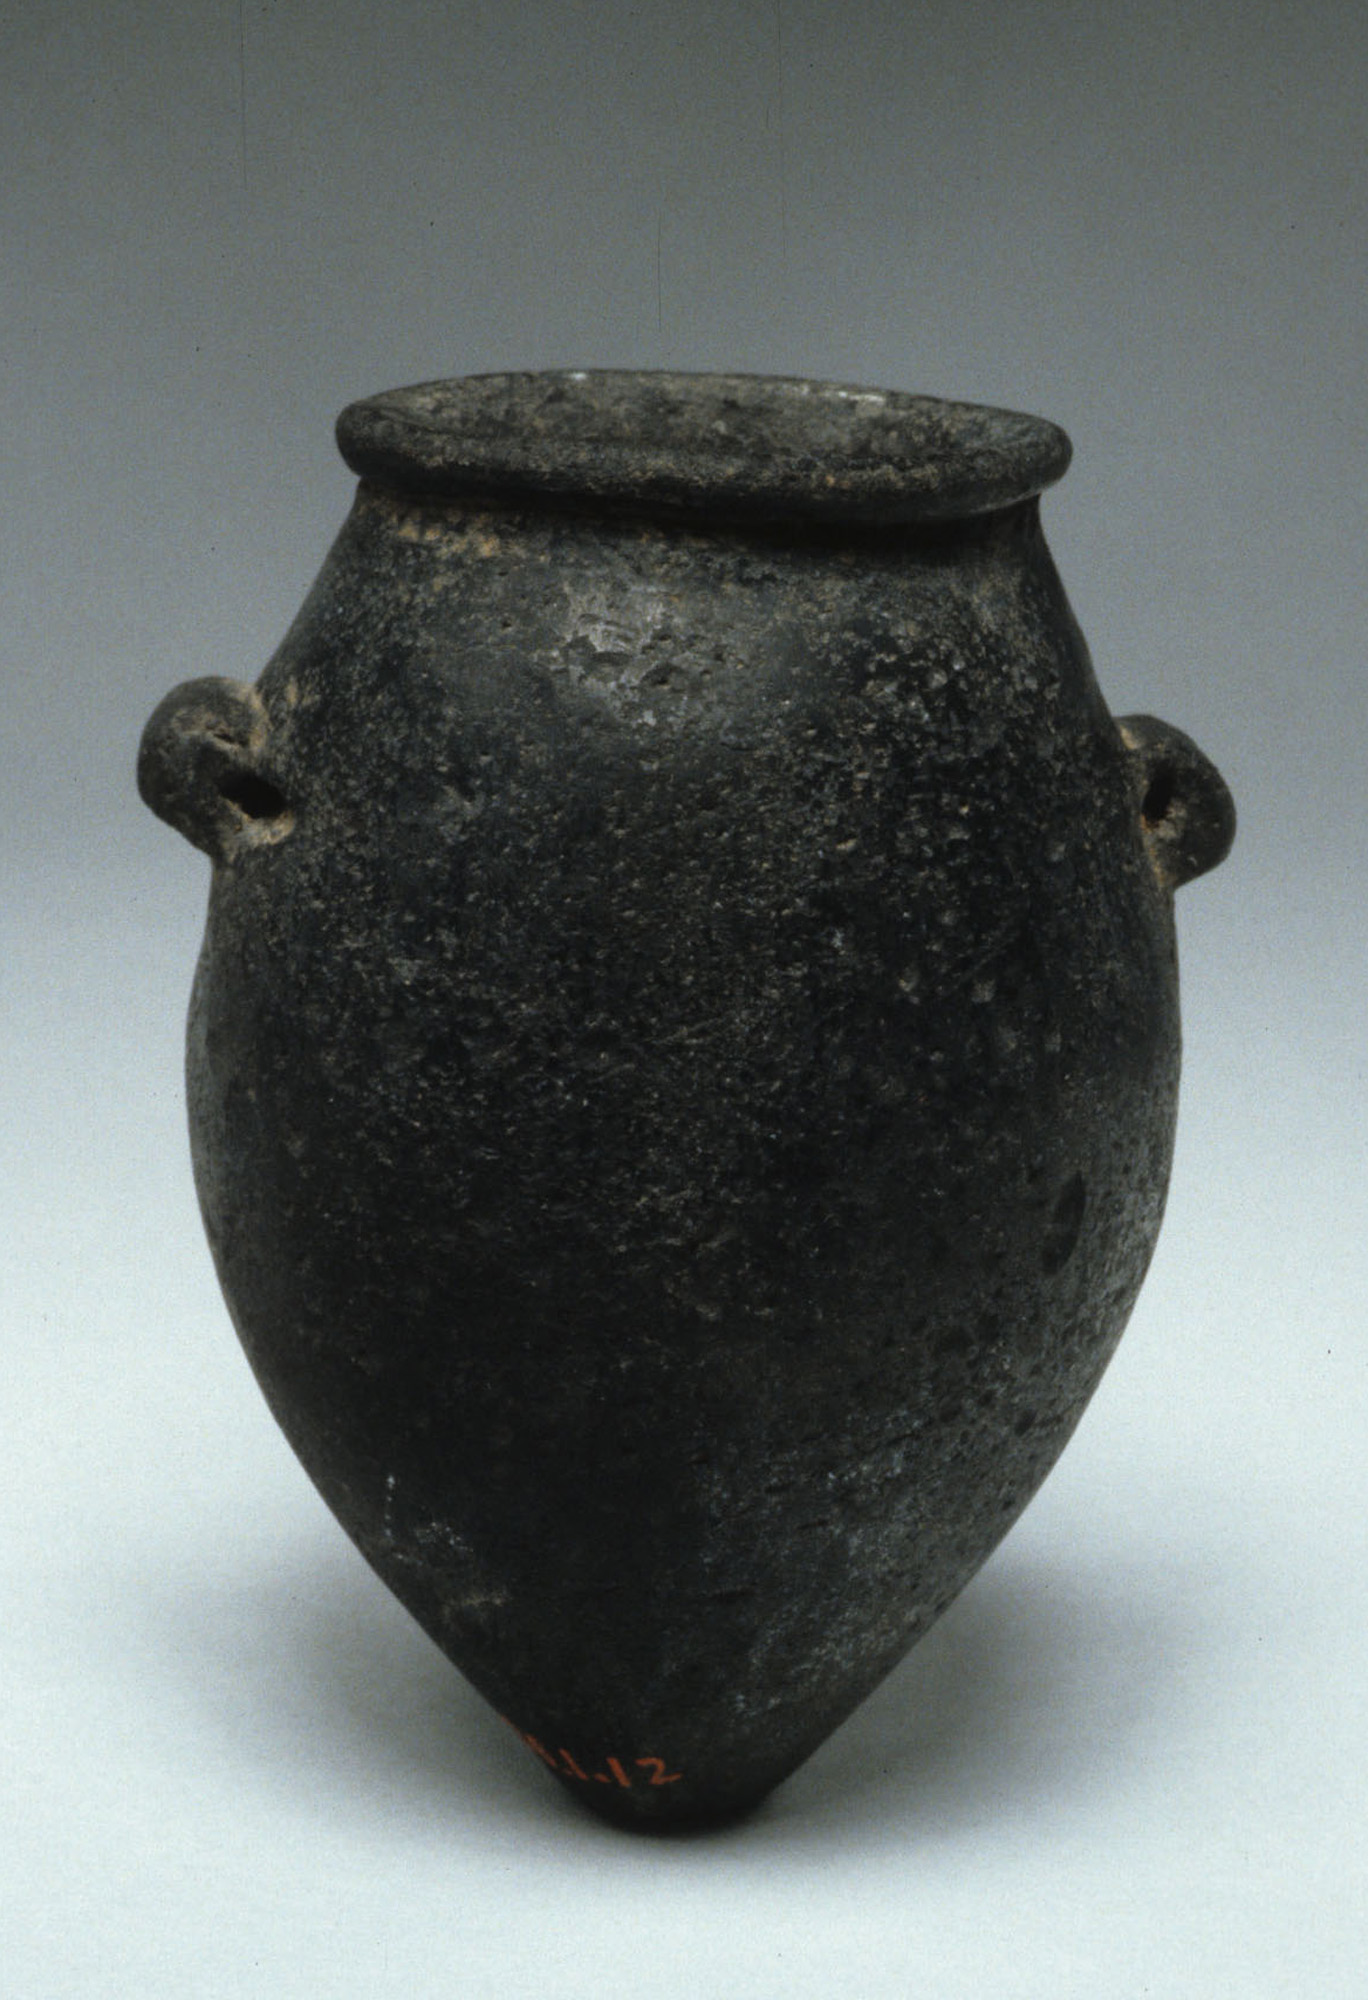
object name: jar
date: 3850-2960 BCE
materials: pottery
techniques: polish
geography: egypt